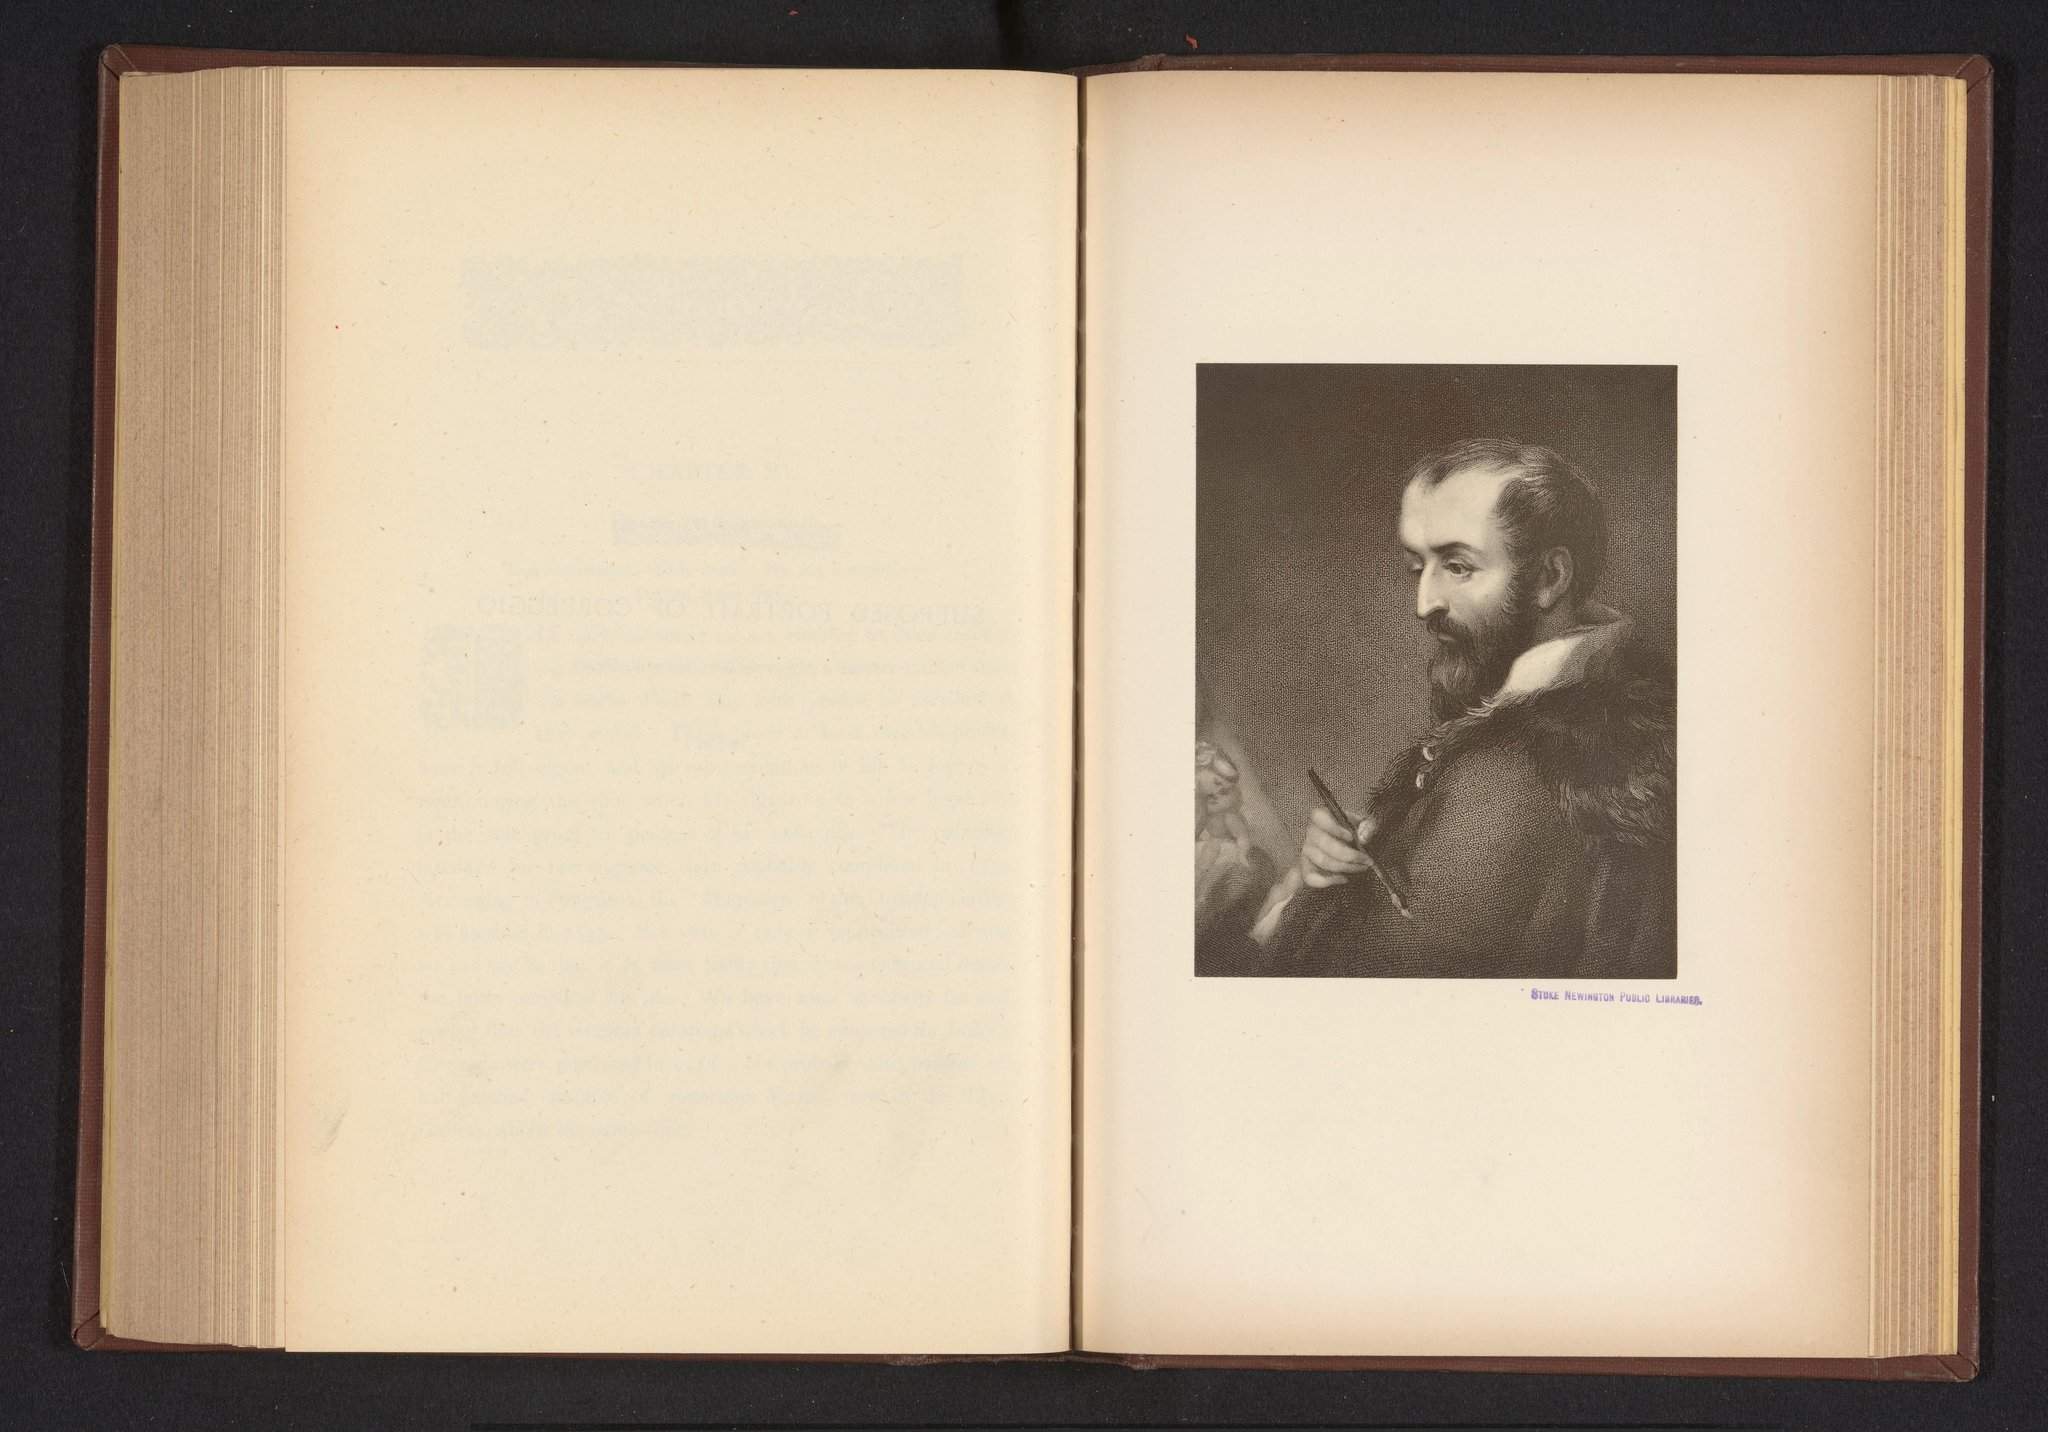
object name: page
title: Fotoreproductie van een prent naar een schilderij, voorstellende een portret van Correggio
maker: Anonymous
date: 1870-1876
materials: paper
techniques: woodburytype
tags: painter, print maker, draughtsman, correggio, portrait, self-portrait of painter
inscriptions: inscription: ‘Stoke Newington Public Libraries’